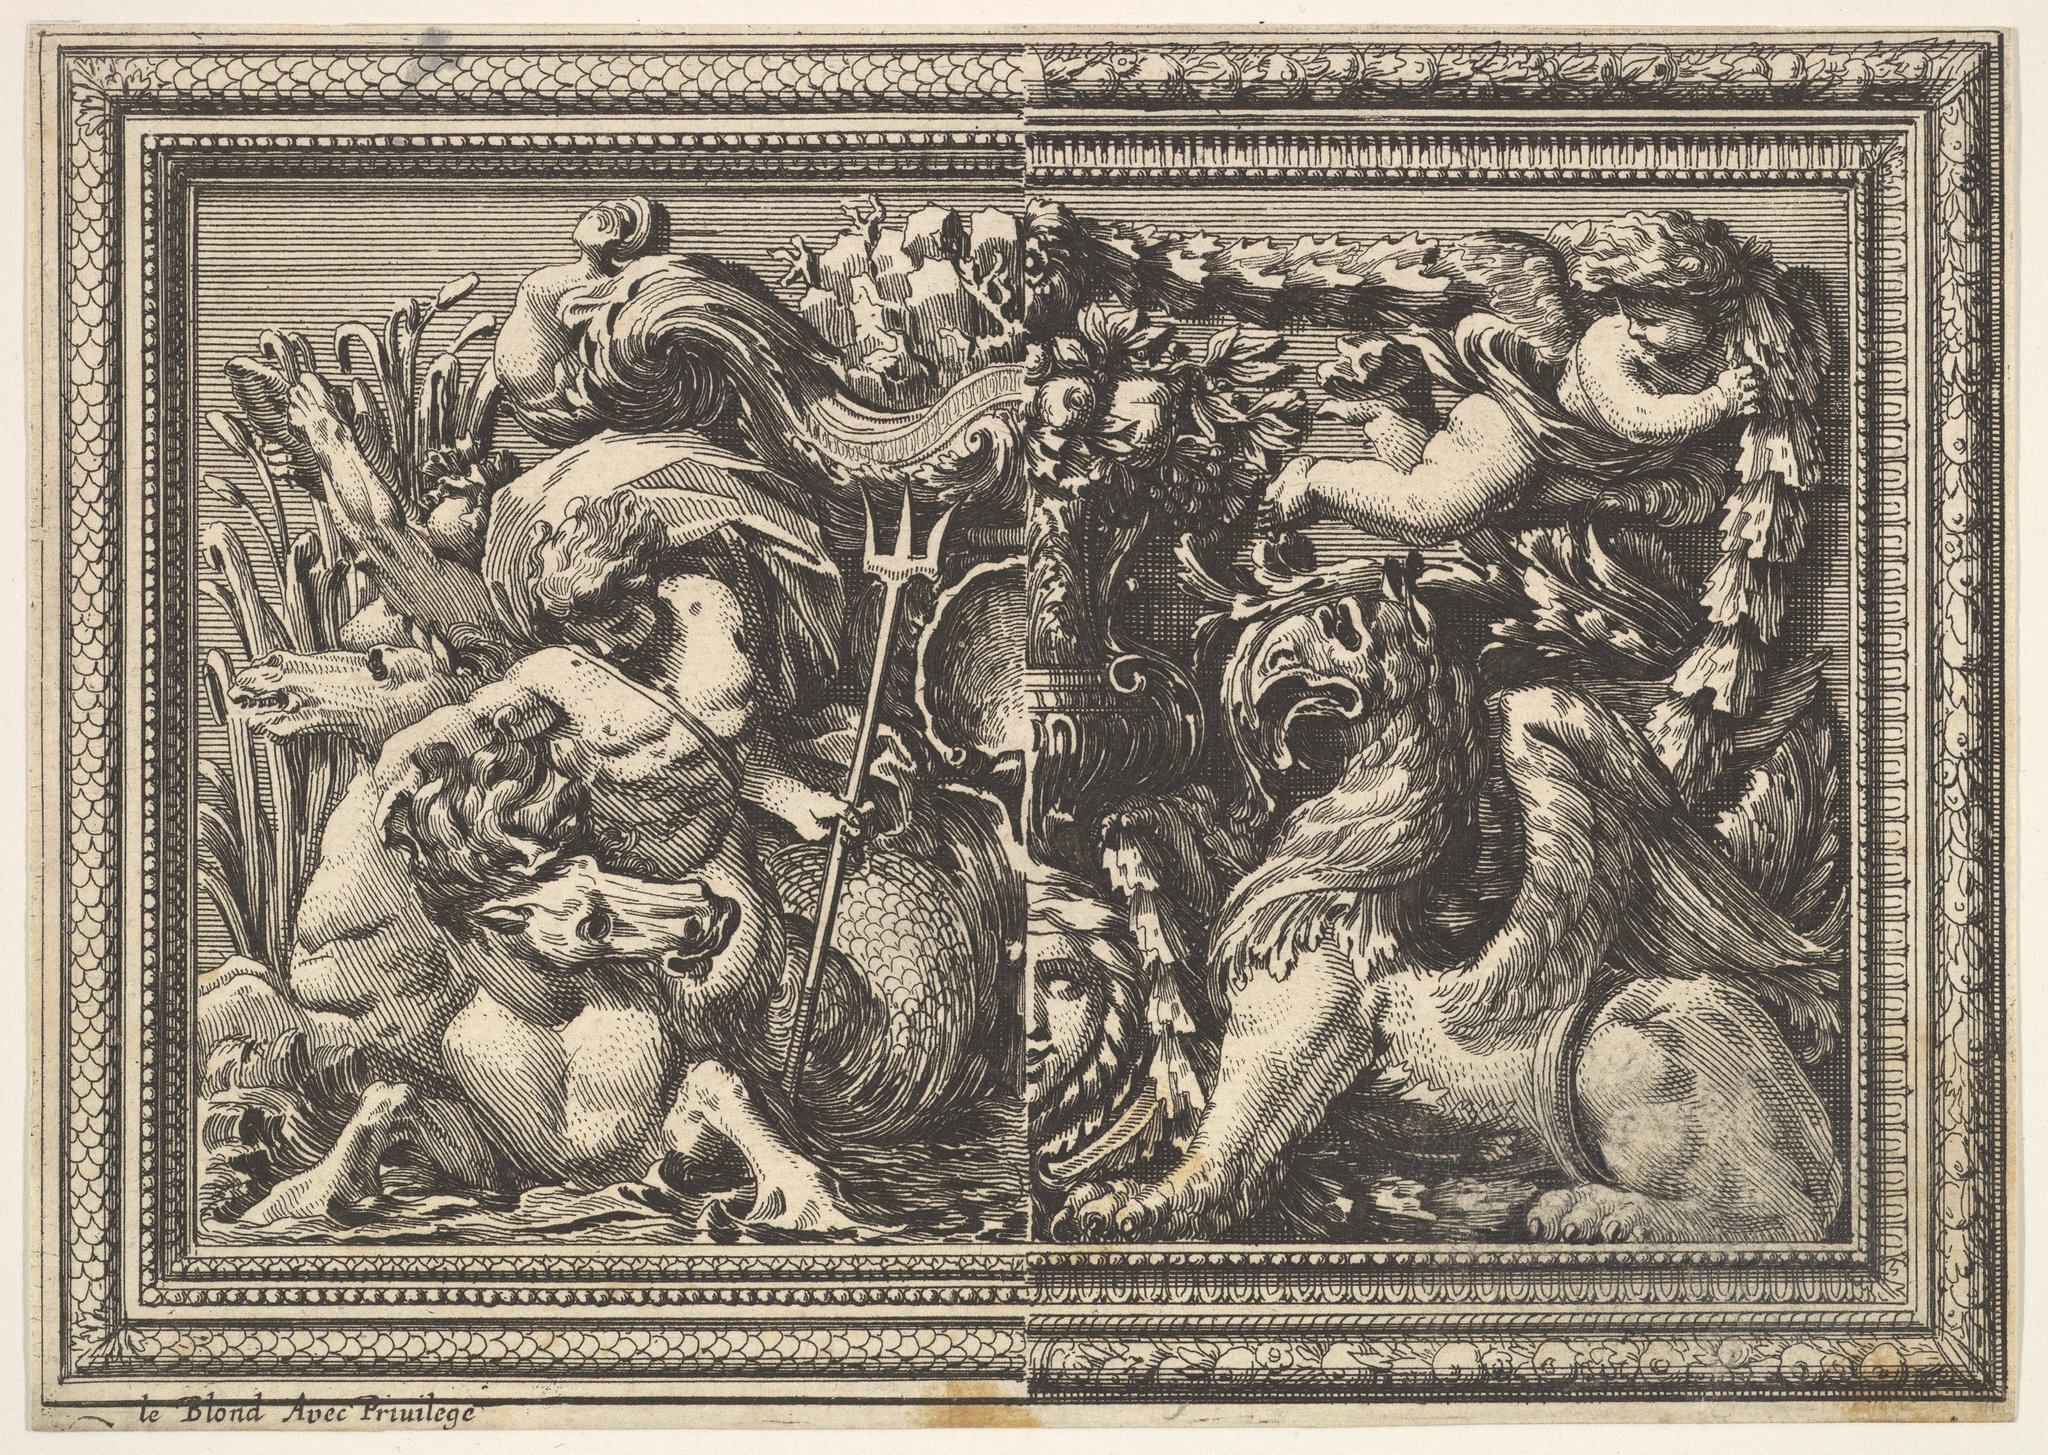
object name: print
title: Design for a Panel with Two Variants containing a Hippocamp and a Griffin, from "Ornements de panneaux à la romaine"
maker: jean le pautre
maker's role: artist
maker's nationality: french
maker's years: 1618-1682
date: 1651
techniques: etching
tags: griffins,hippocamps